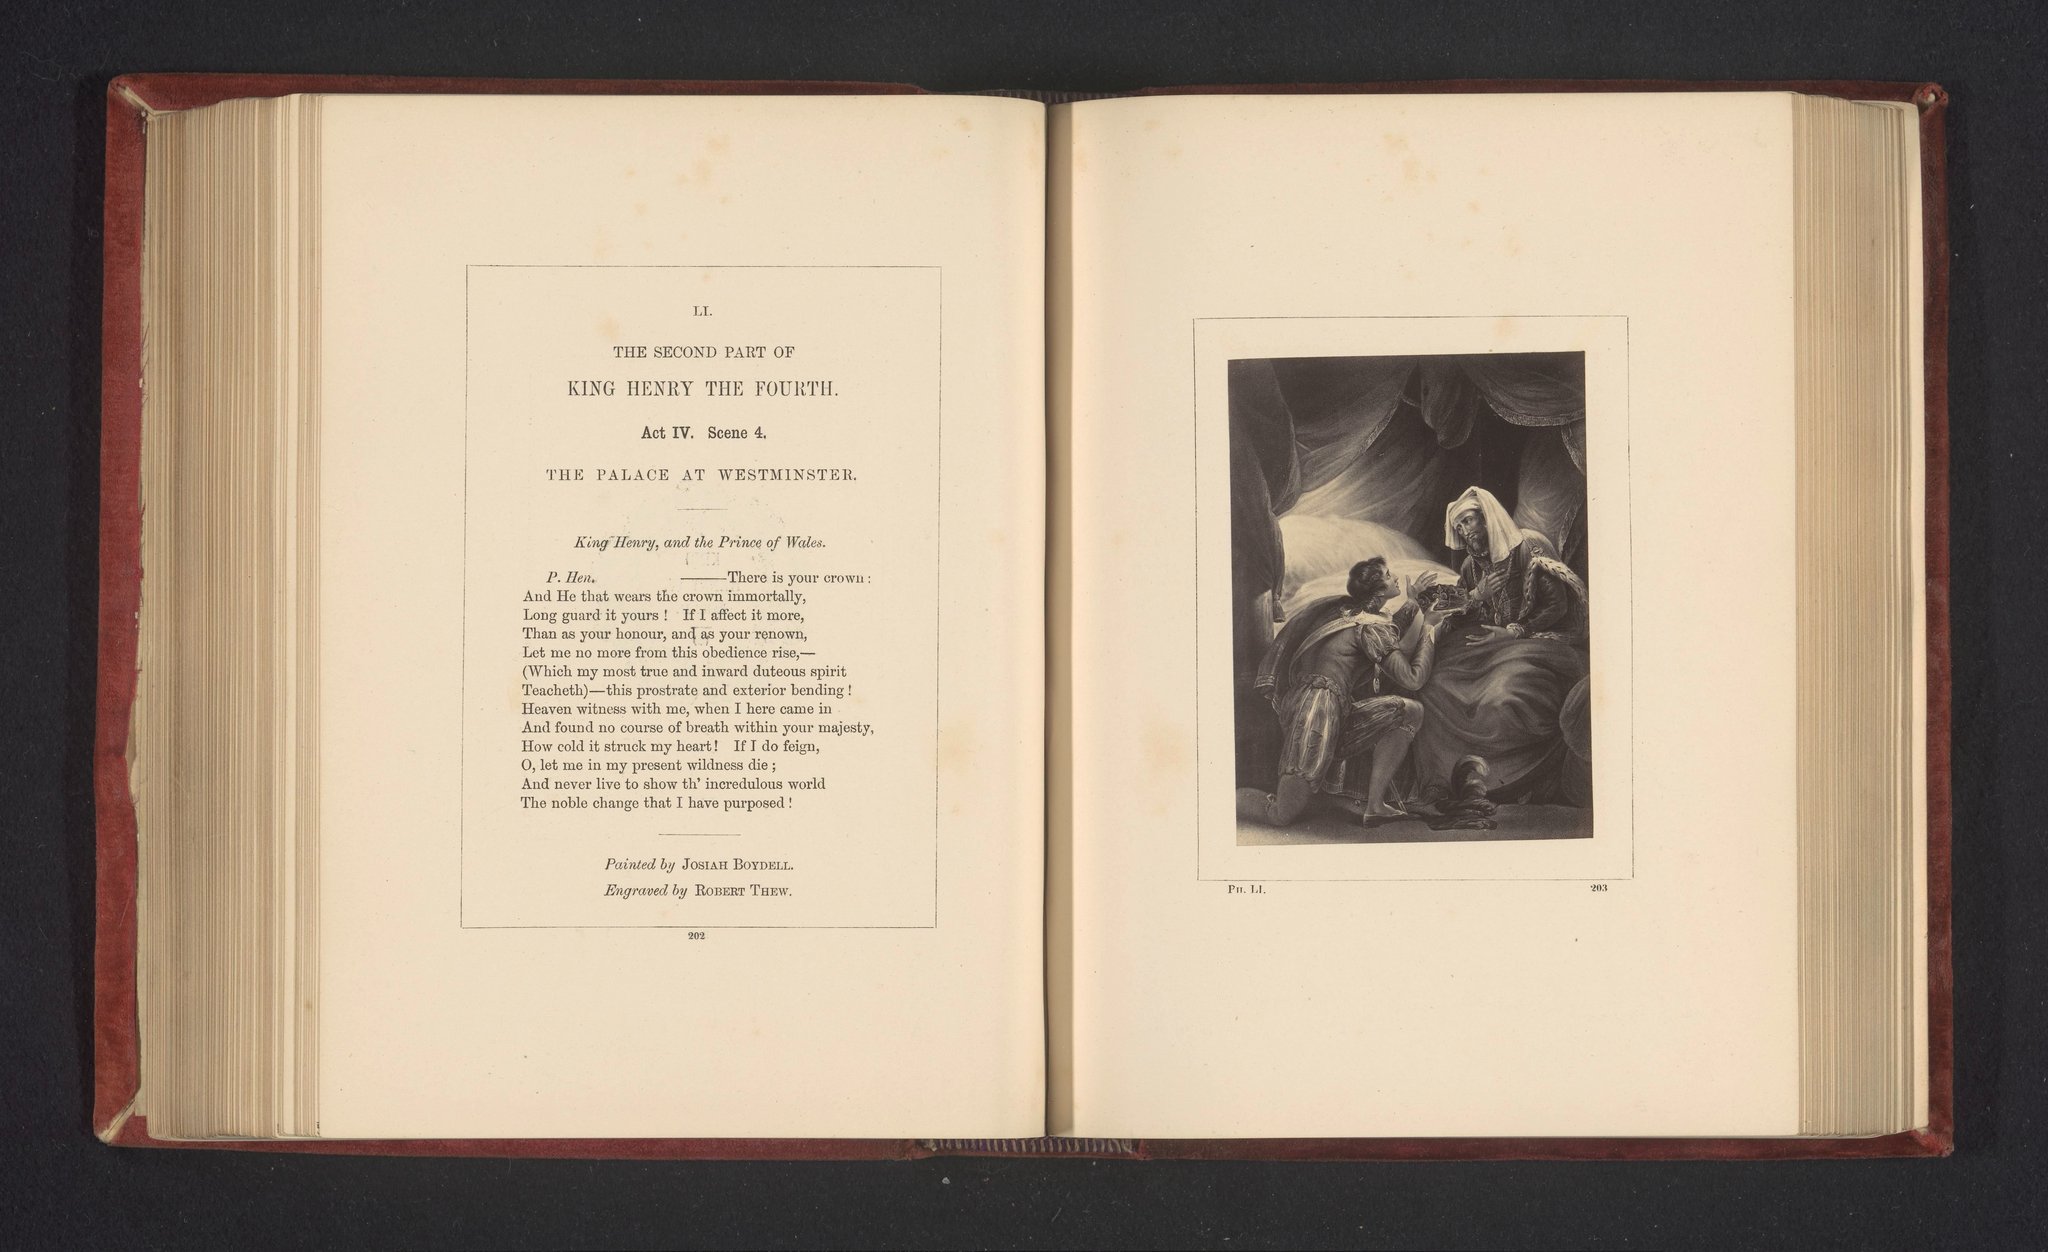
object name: page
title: Fotoreproductie van een prent naar een schilderij door Josiah Boydell, voorstellend een scene uit Hendrik IV door William Shakespeare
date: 1854-1864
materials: photographic support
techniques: albumen print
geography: london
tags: specific works of literature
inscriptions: number: ‘Ph. LI. 203’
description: Te zien is akte IV, scene 4 met koning Hendrik IV zittend in bed met prins Harry ervoor.